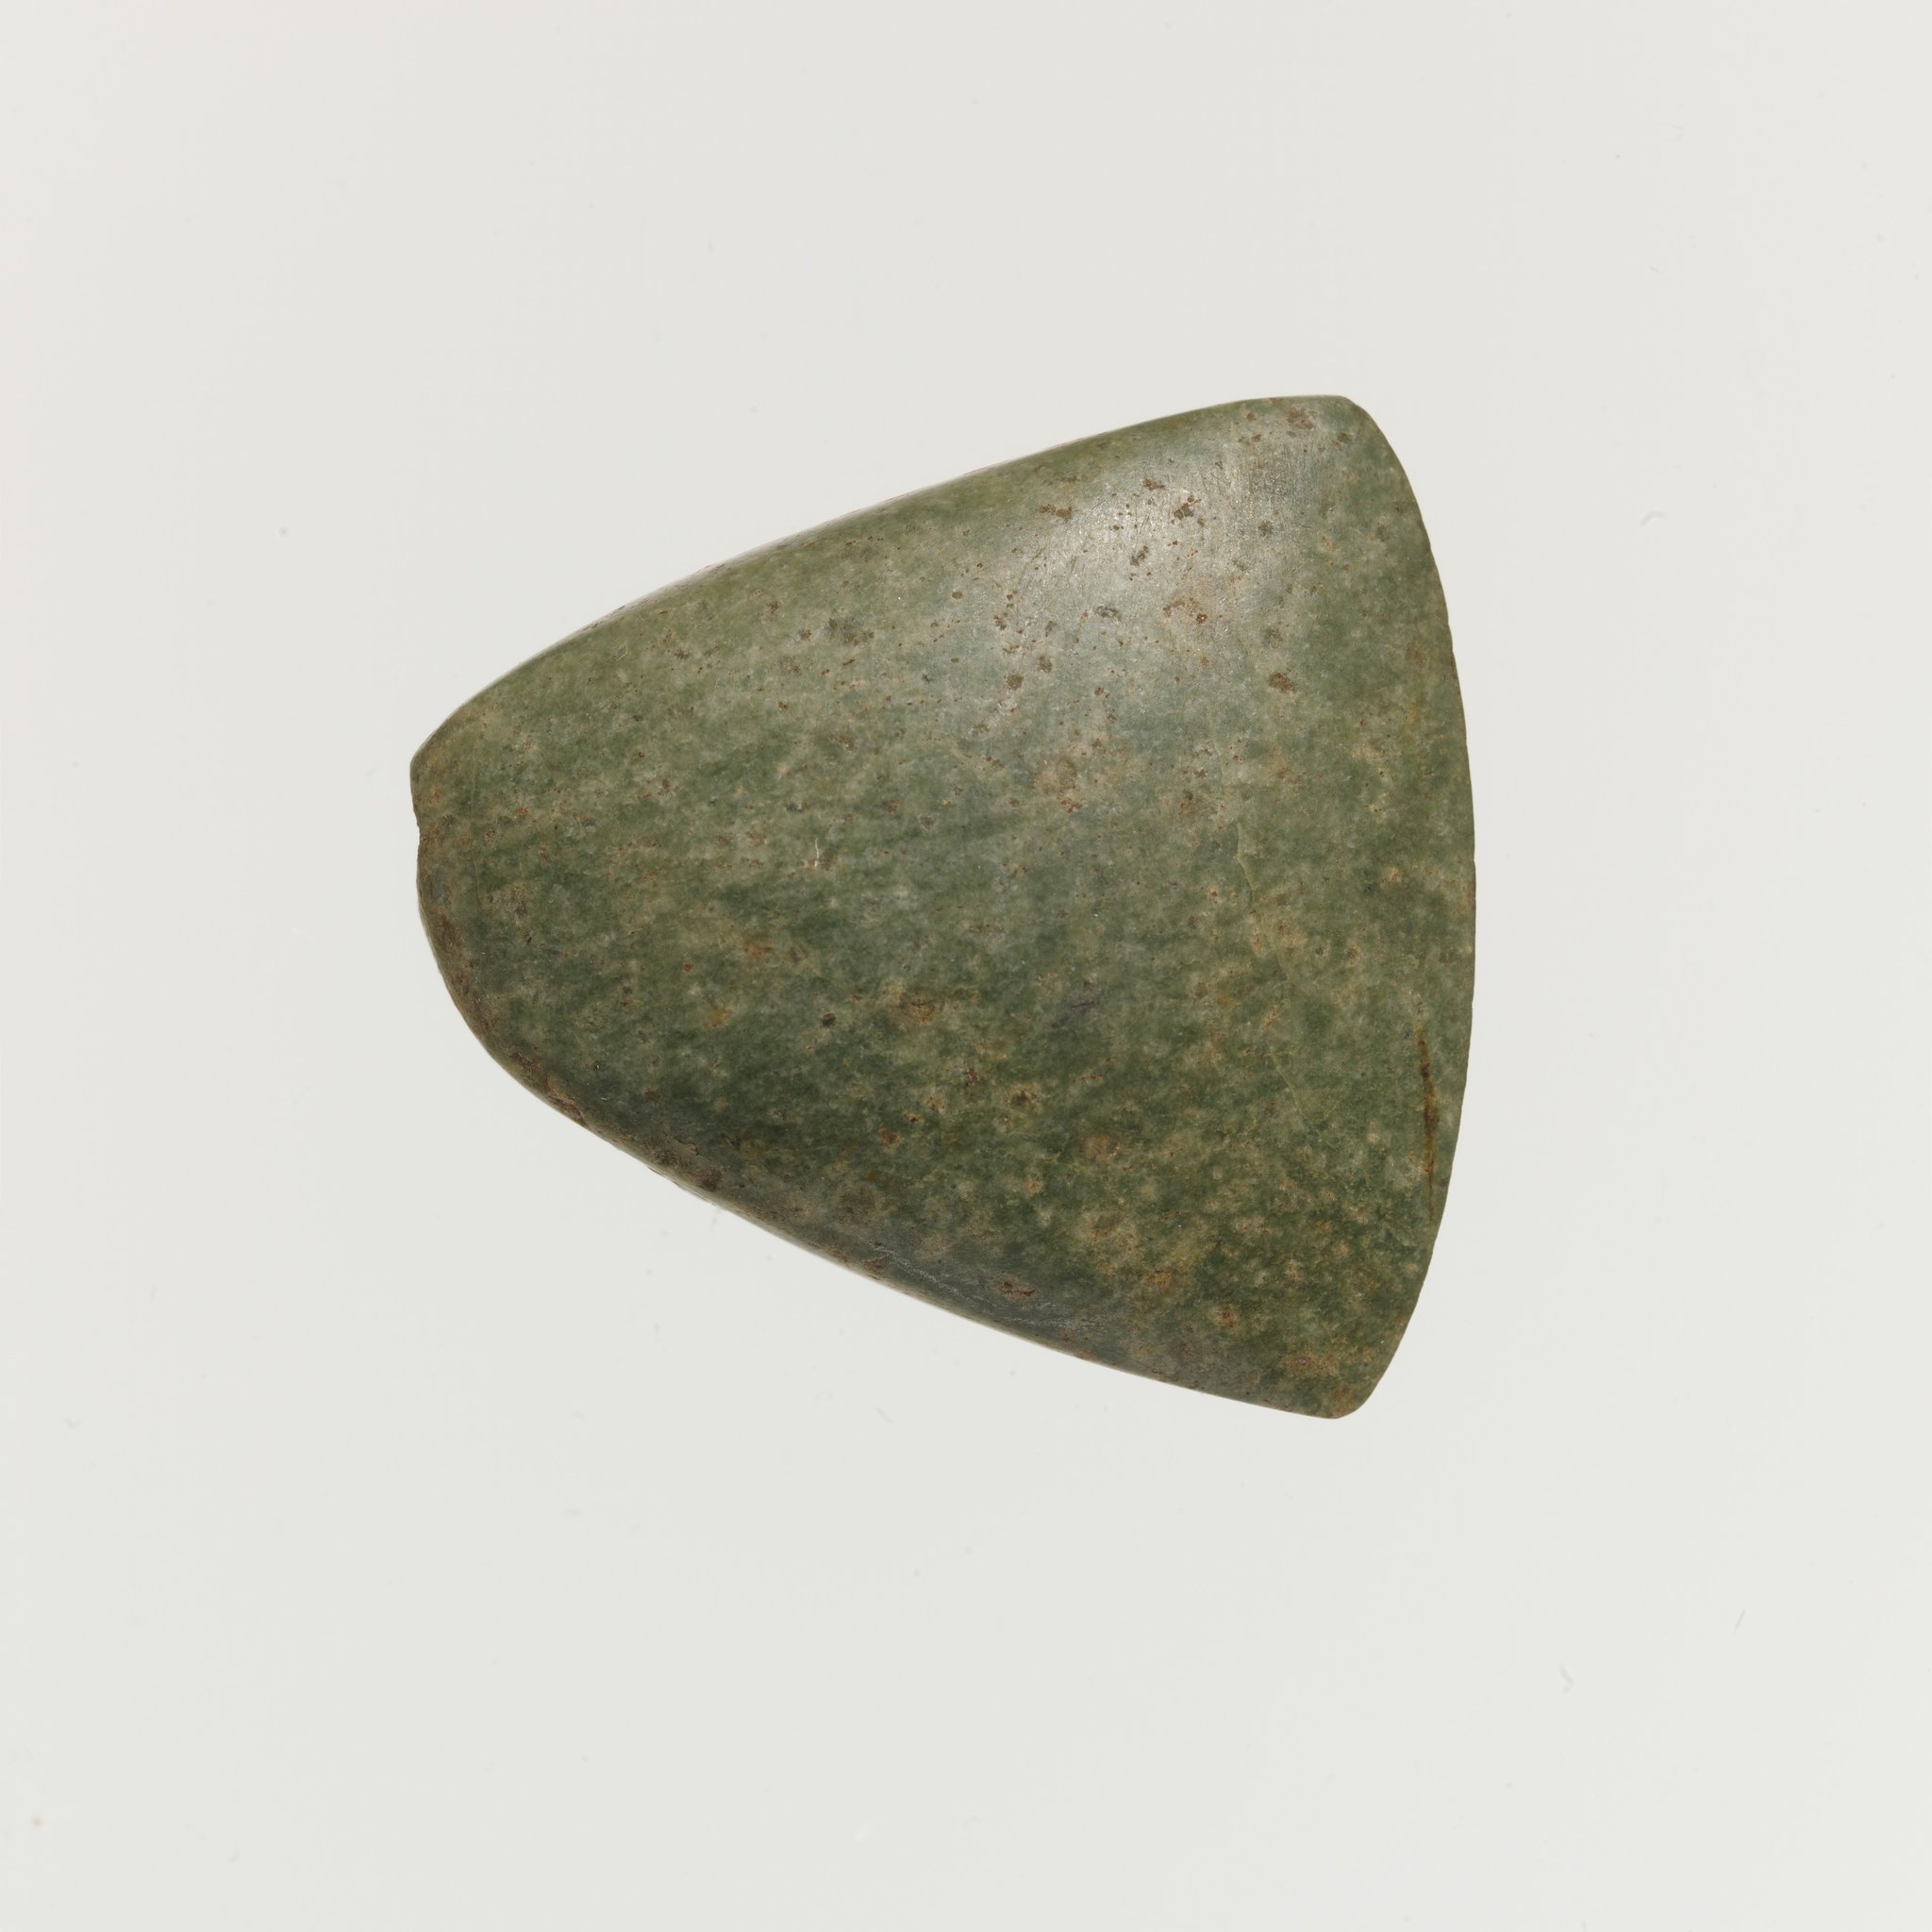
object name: celt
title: Small jadeitite axe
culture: cretan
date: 5000-3001 BCE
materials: stone